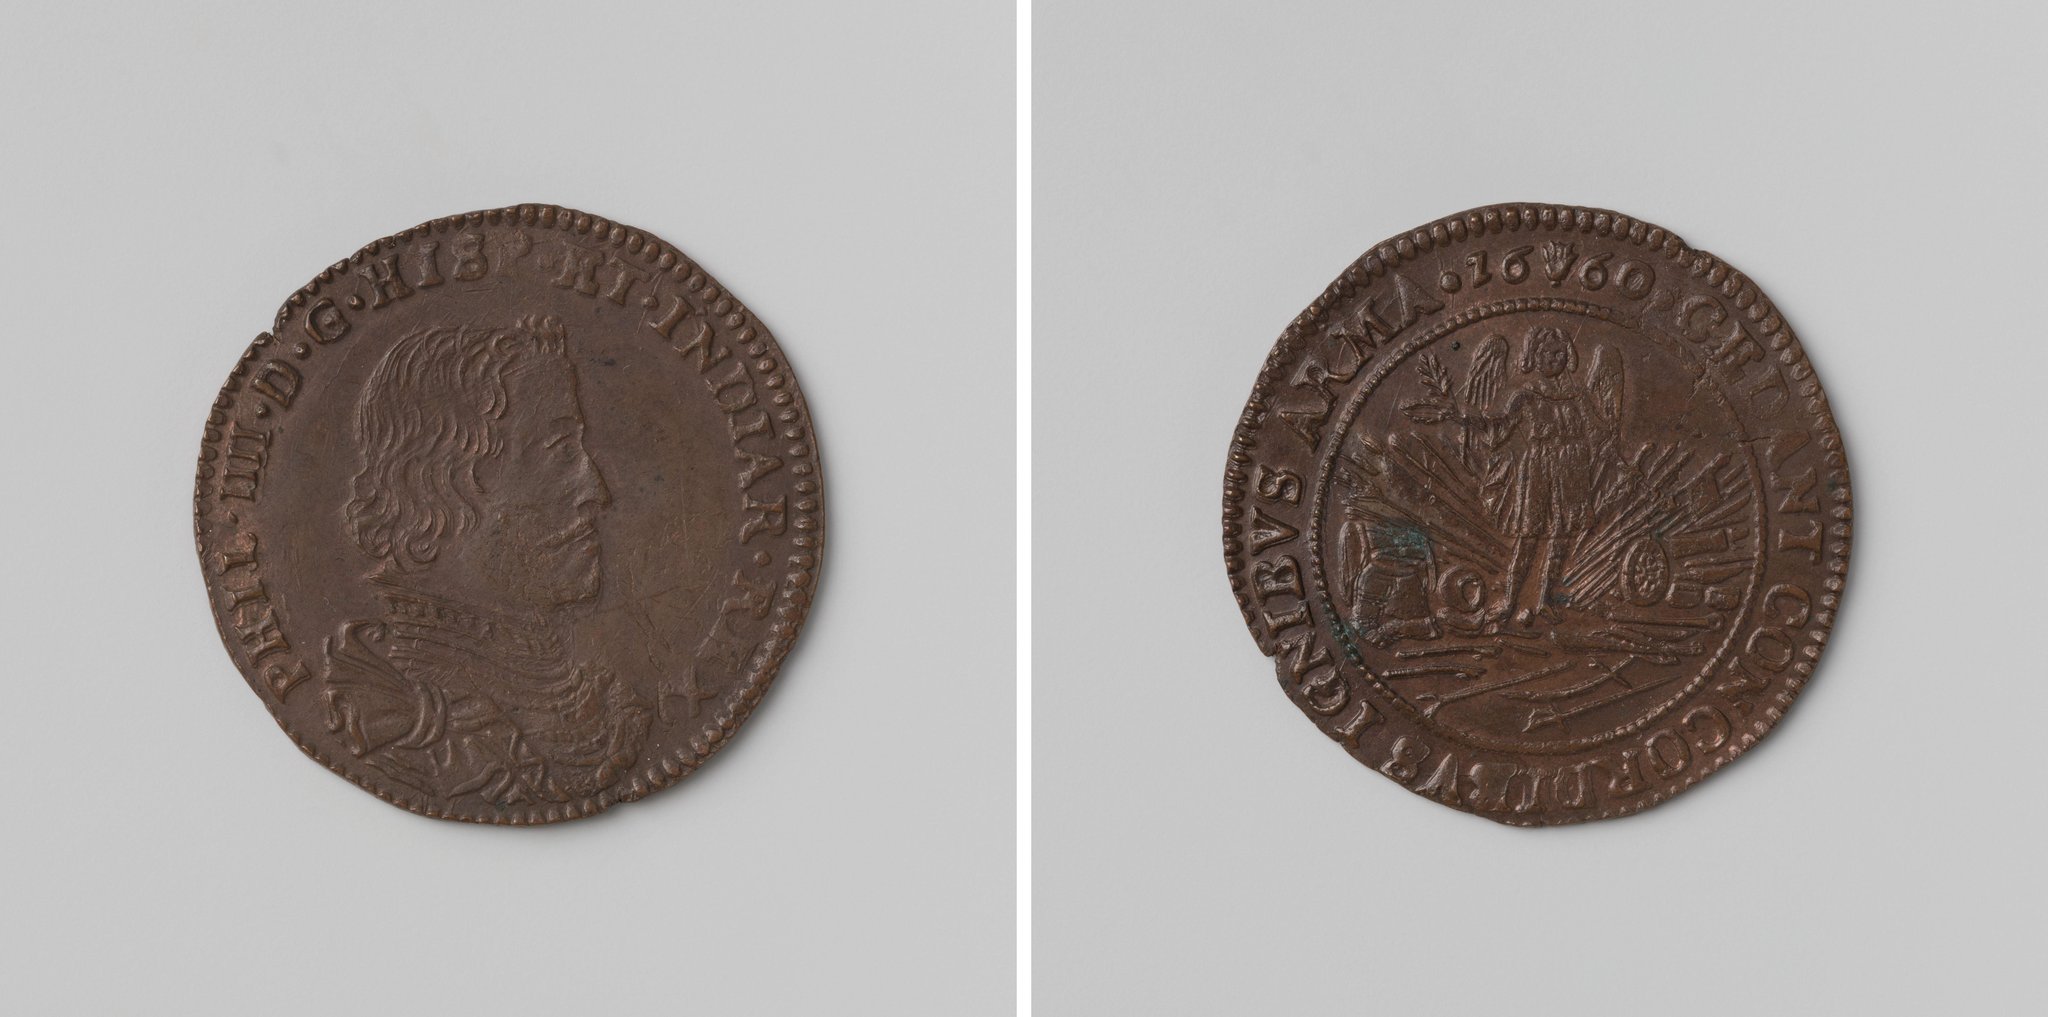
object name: jeton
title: Vrede van de Pyreneeën tussen Frankrijk en Spanje en huwelijk van Lodewijk XIV, koning van Frankrijk met Maria Theresia van Oostenrijk, rekenpenning geslagen ter ere van Filips IV, koning van Spanje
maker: Anonymous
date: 1660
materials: copper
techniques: striking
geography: antwerp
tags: filips iv (koning van spanje), lodewijk xiv (koning van frankrijk), maria theresia (koningin van frankrijk), france, spain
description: Koperen penning. Voorzijde: borststuk man binnen omschrift. Keerzijde: gevleugelde huwelijksgod Hymen met olijftak en myrtekrans in rechter- en toorts in linkerhand, steekt stapel krijgstuig in brand binnen omschrift